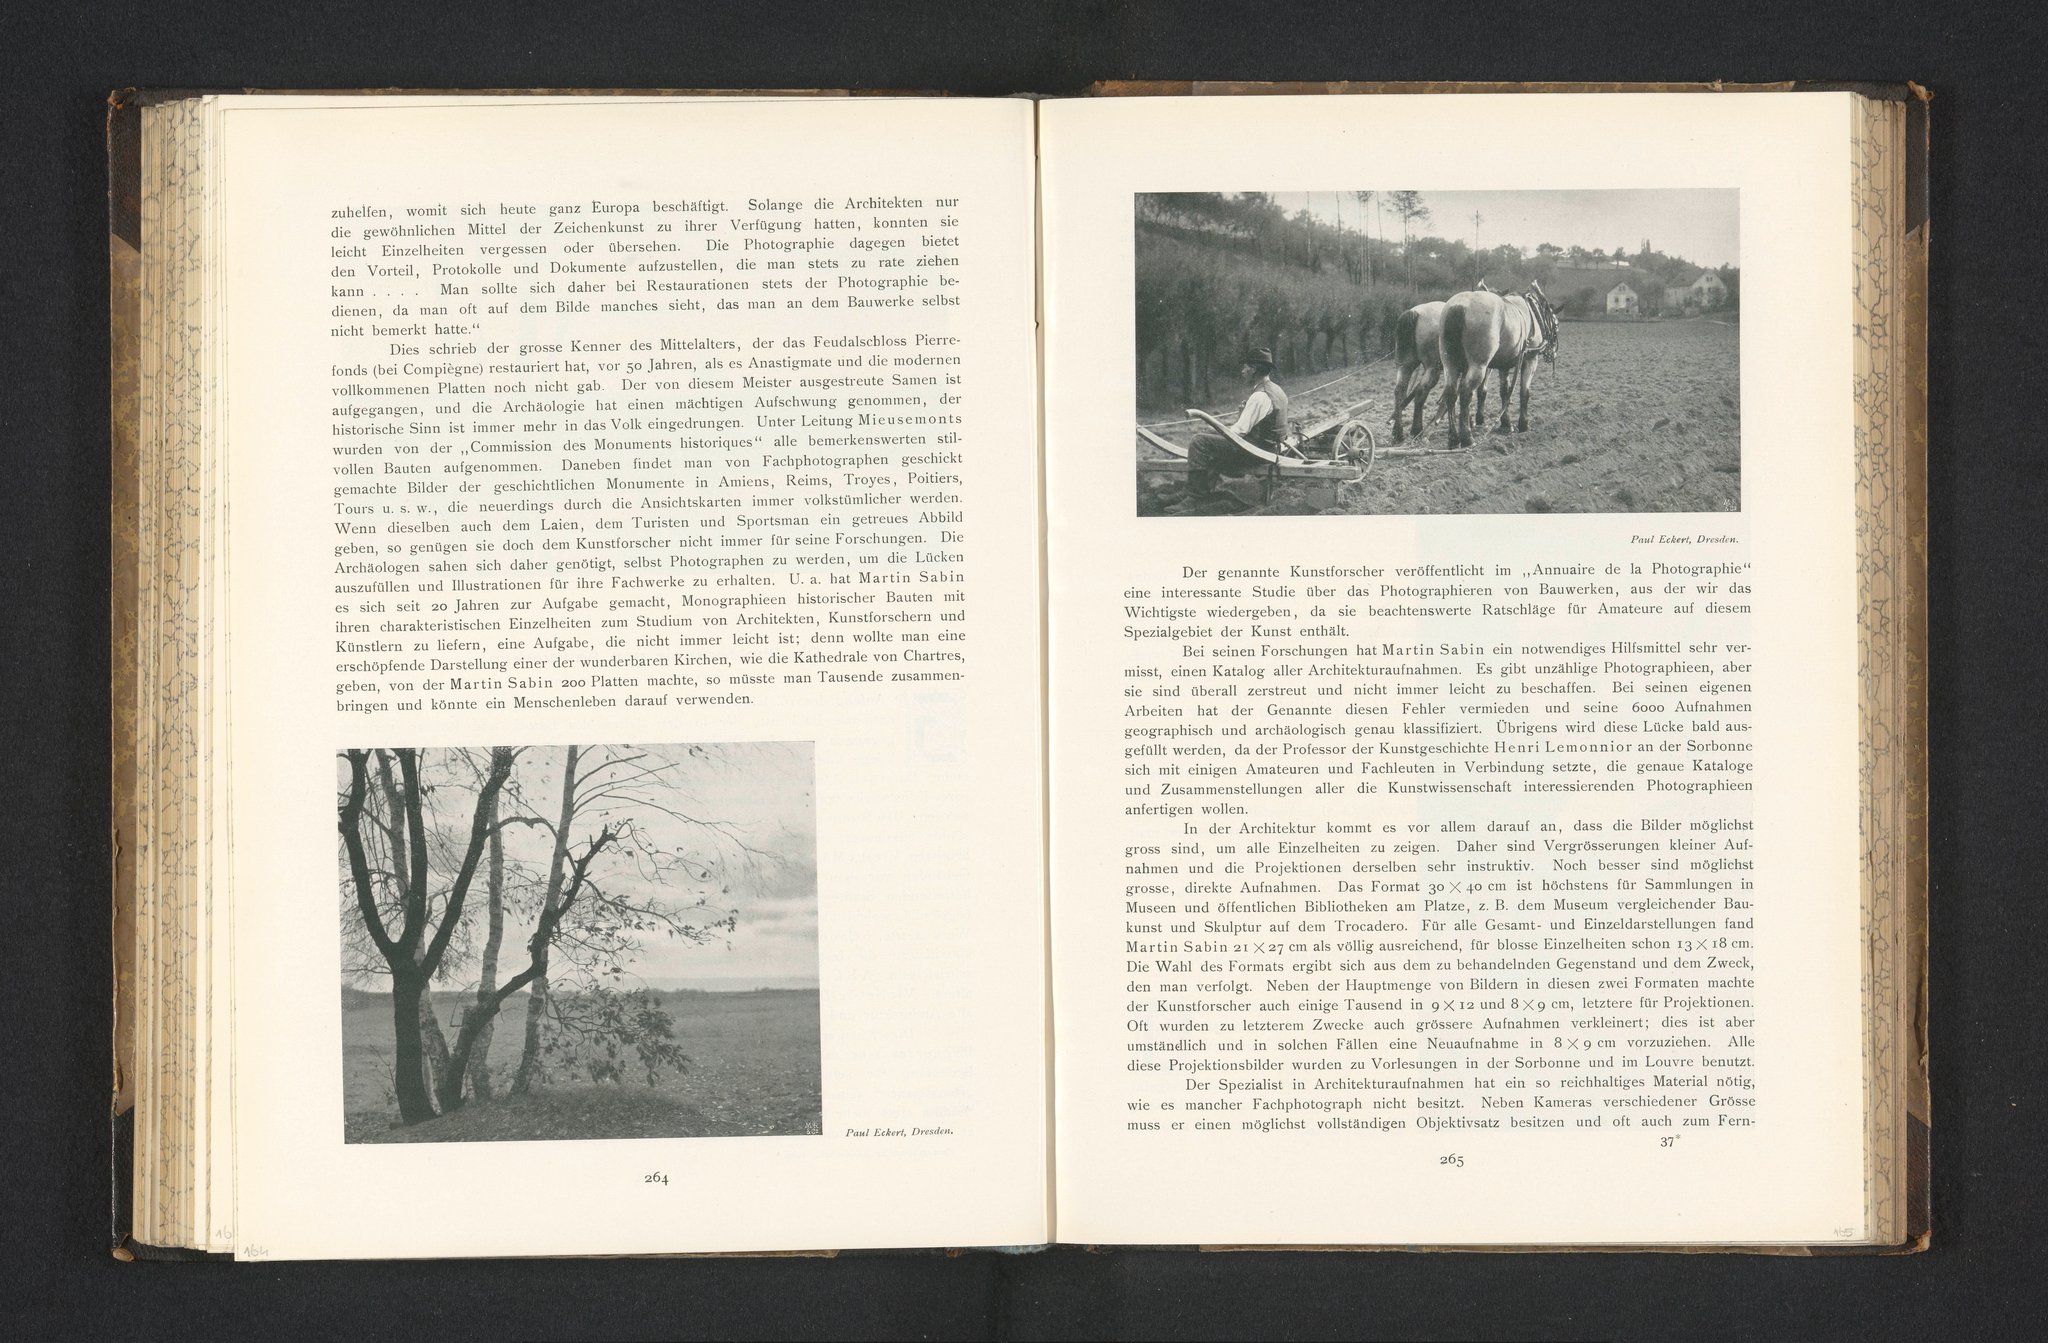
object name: photomechanical print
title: Boer aan het werk op het land met twee paarden voor een werktuig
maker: paul eckert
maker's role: fotograaf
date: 1898-1903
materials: paper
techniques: autotype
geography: berlin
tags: farmers, soil cultivation, horse